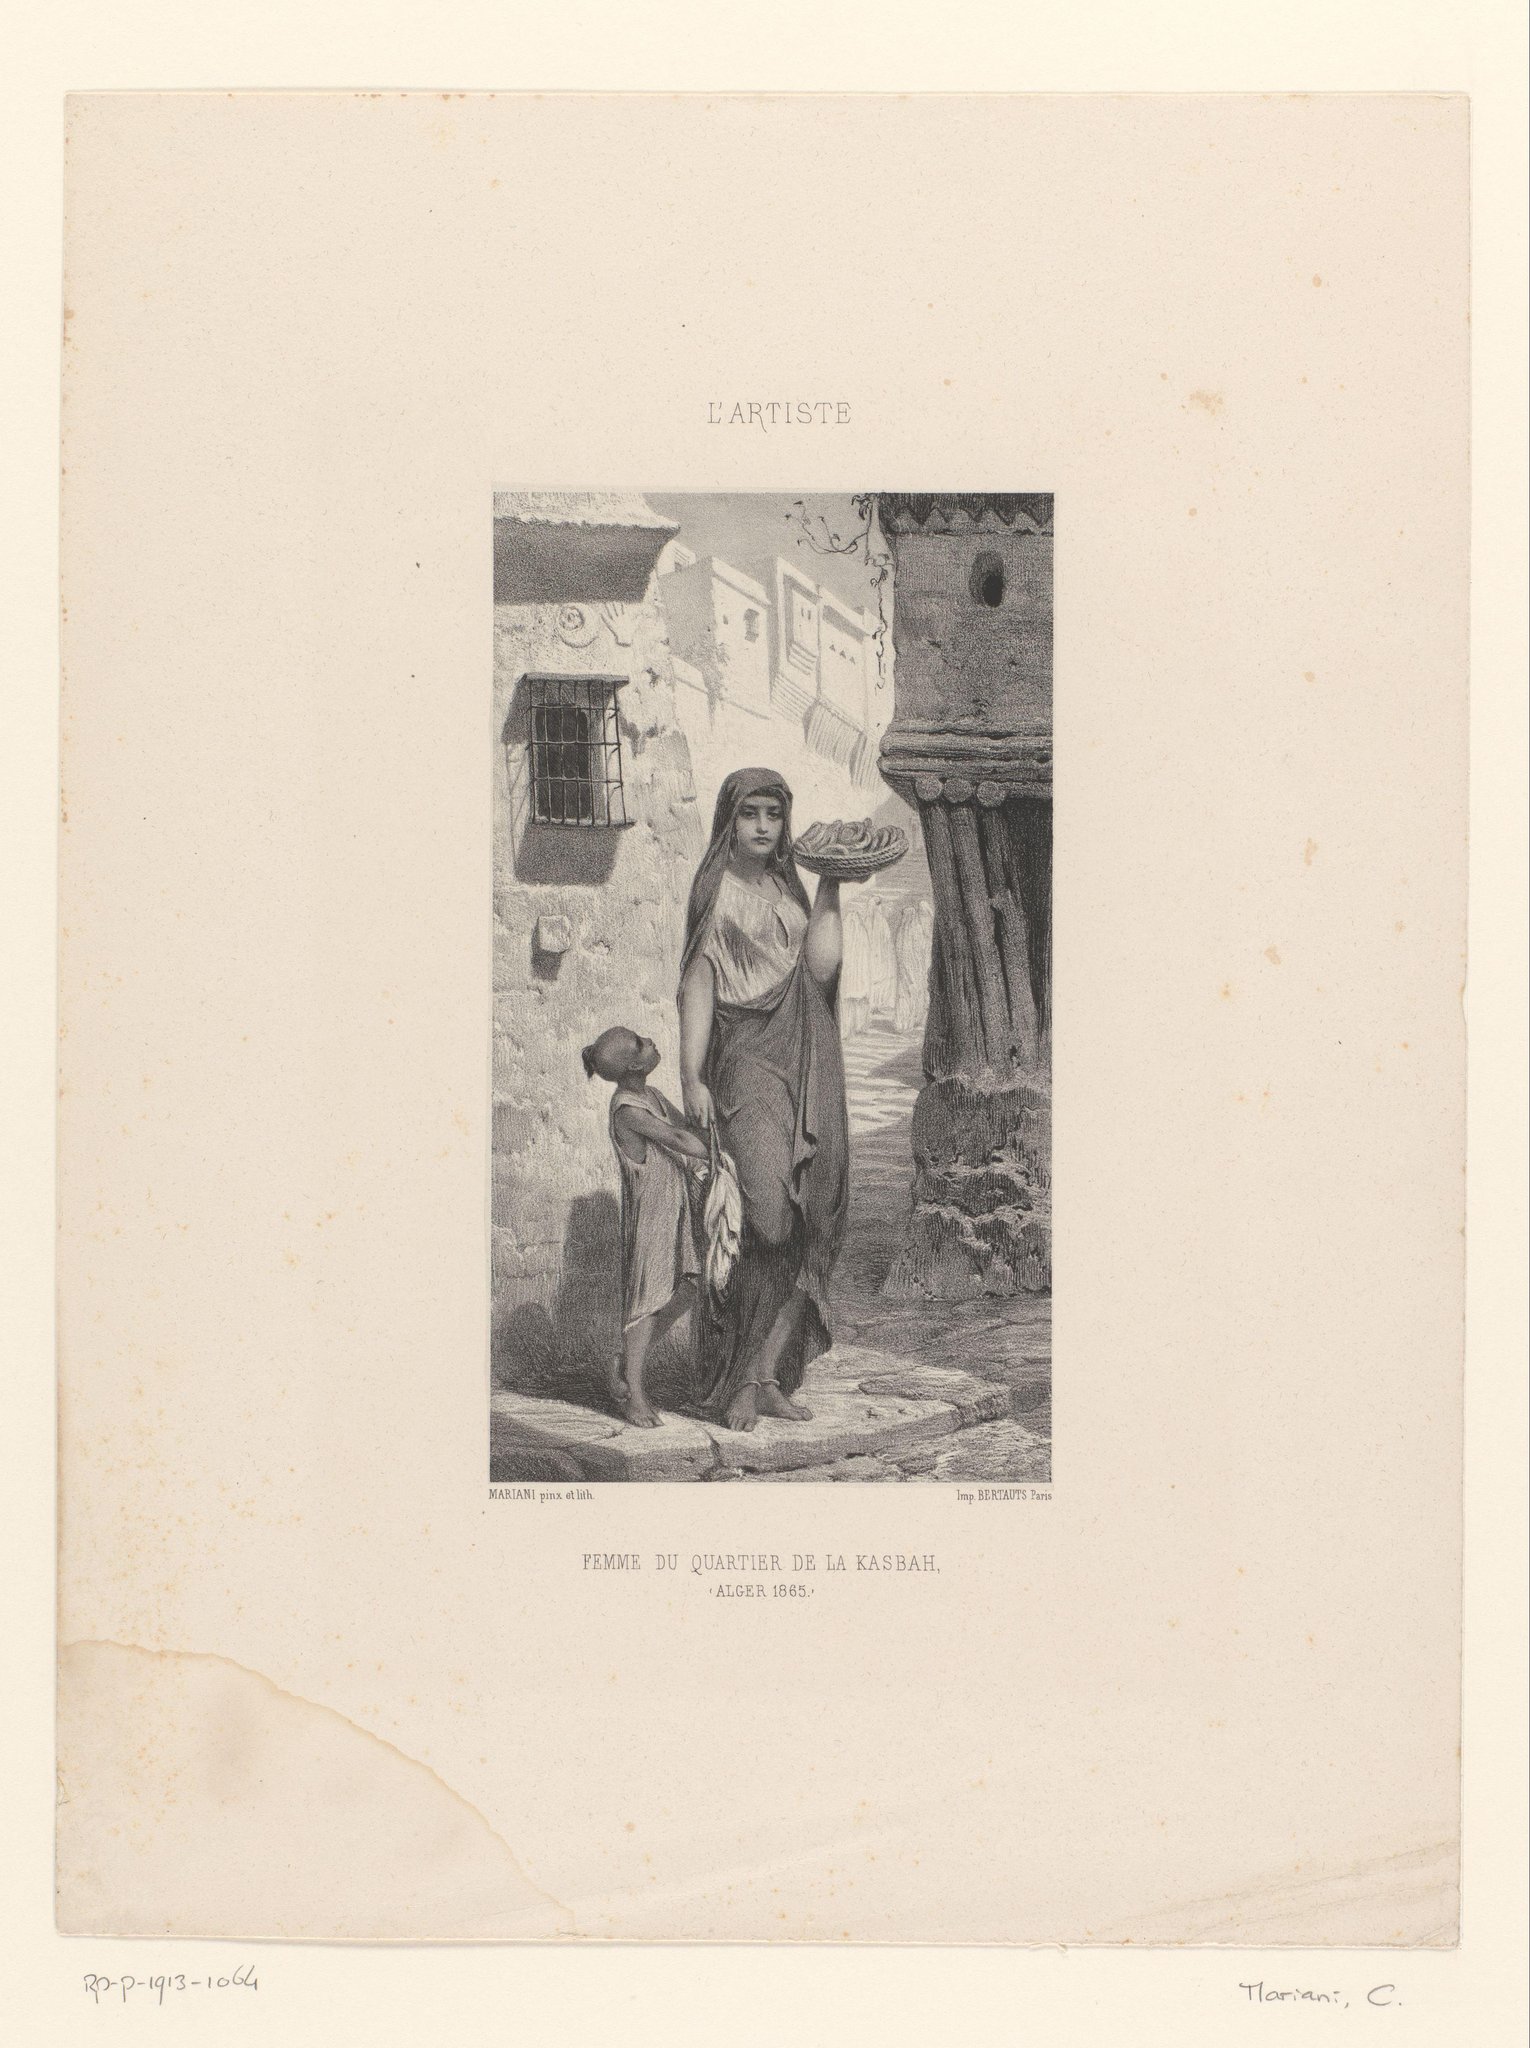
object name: print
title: Femme du quartier de la Kasbah/ Alger 1865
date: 1865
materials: paper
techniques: lithograph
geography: italy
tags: mother and baby or young child, street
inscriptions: collector's mark: Lugt 2228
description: Een vrouw loopt met een schaal eten in haar hand, samen met haar zoon, door de straten van de kasba te Algerije.